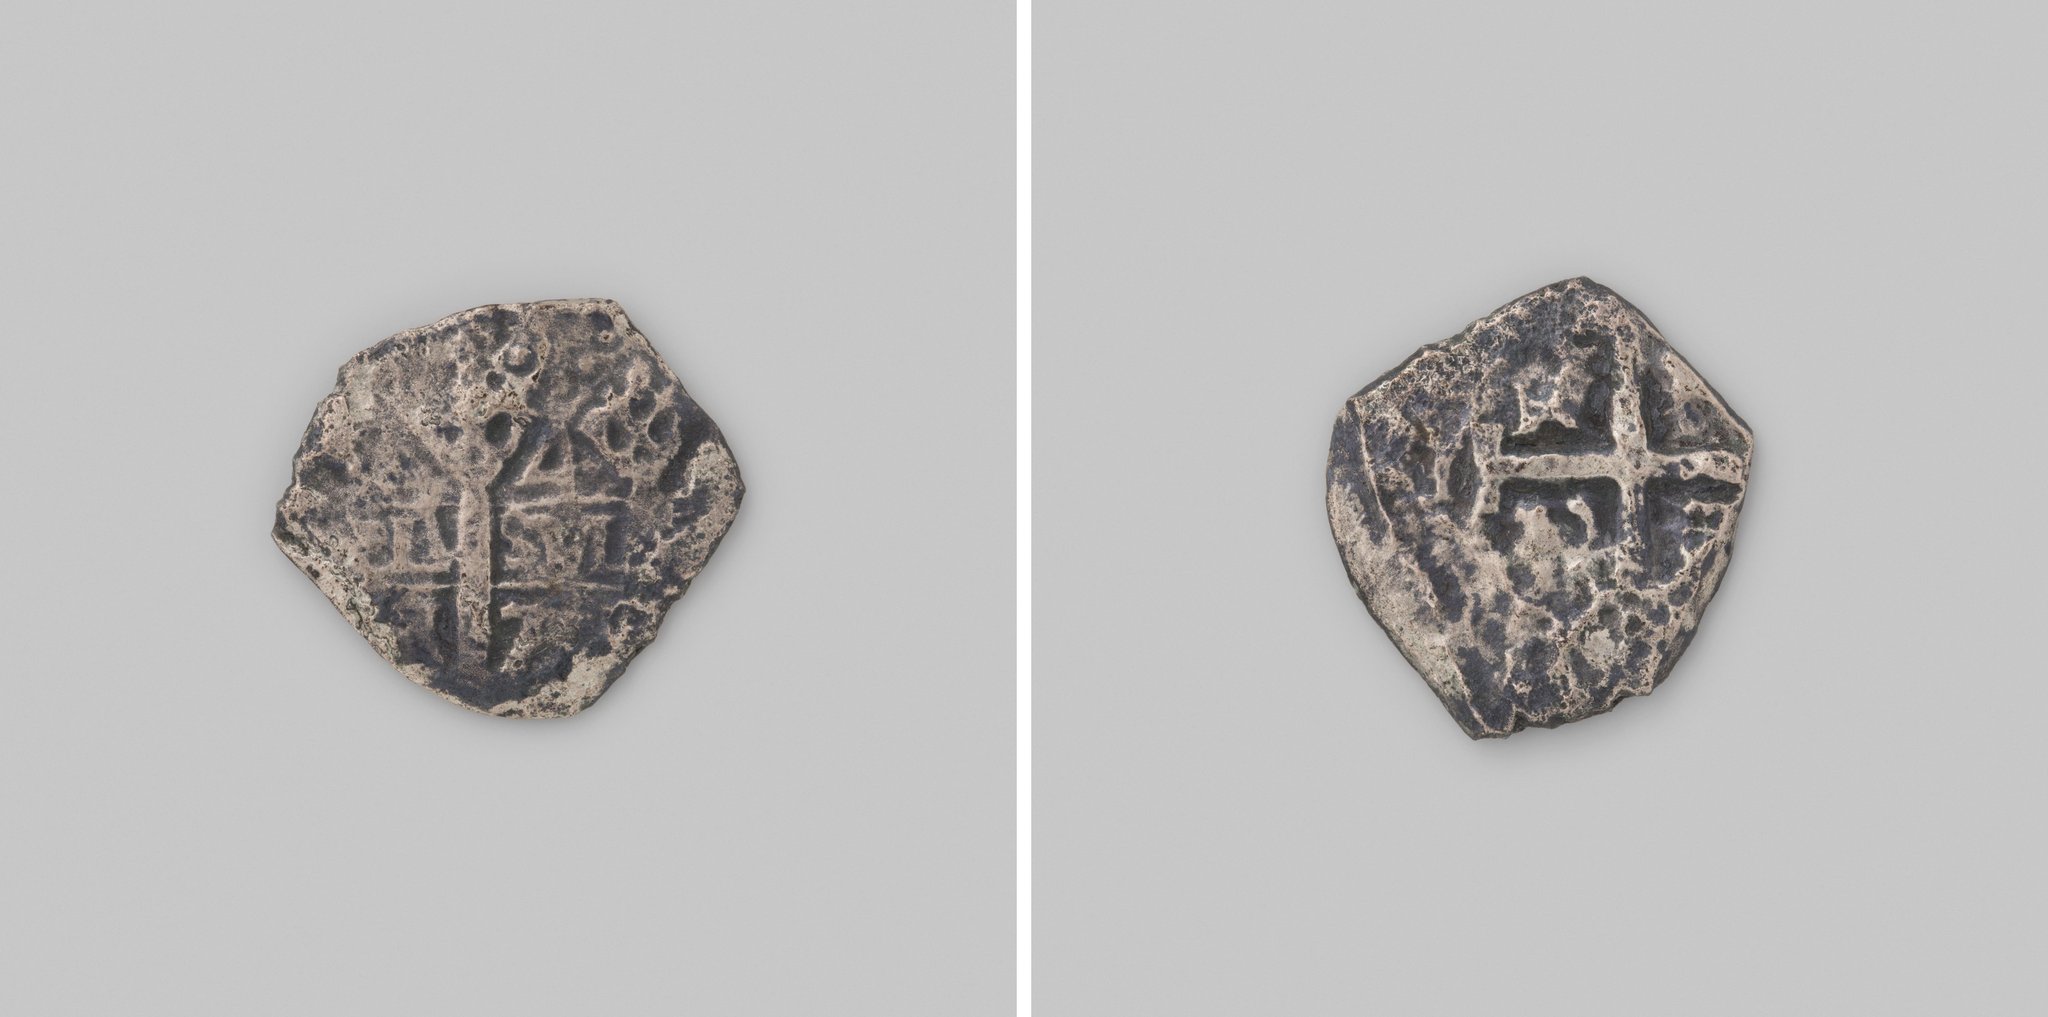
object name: vier reaal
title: Reaal van vieren, geslagen te Lima, munt uit het wrak van de Oost-Indiëvaarder 't Vliegend Hart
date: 1700-1734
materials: silver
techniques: striking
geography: lima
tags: filips v (koning van spanje)